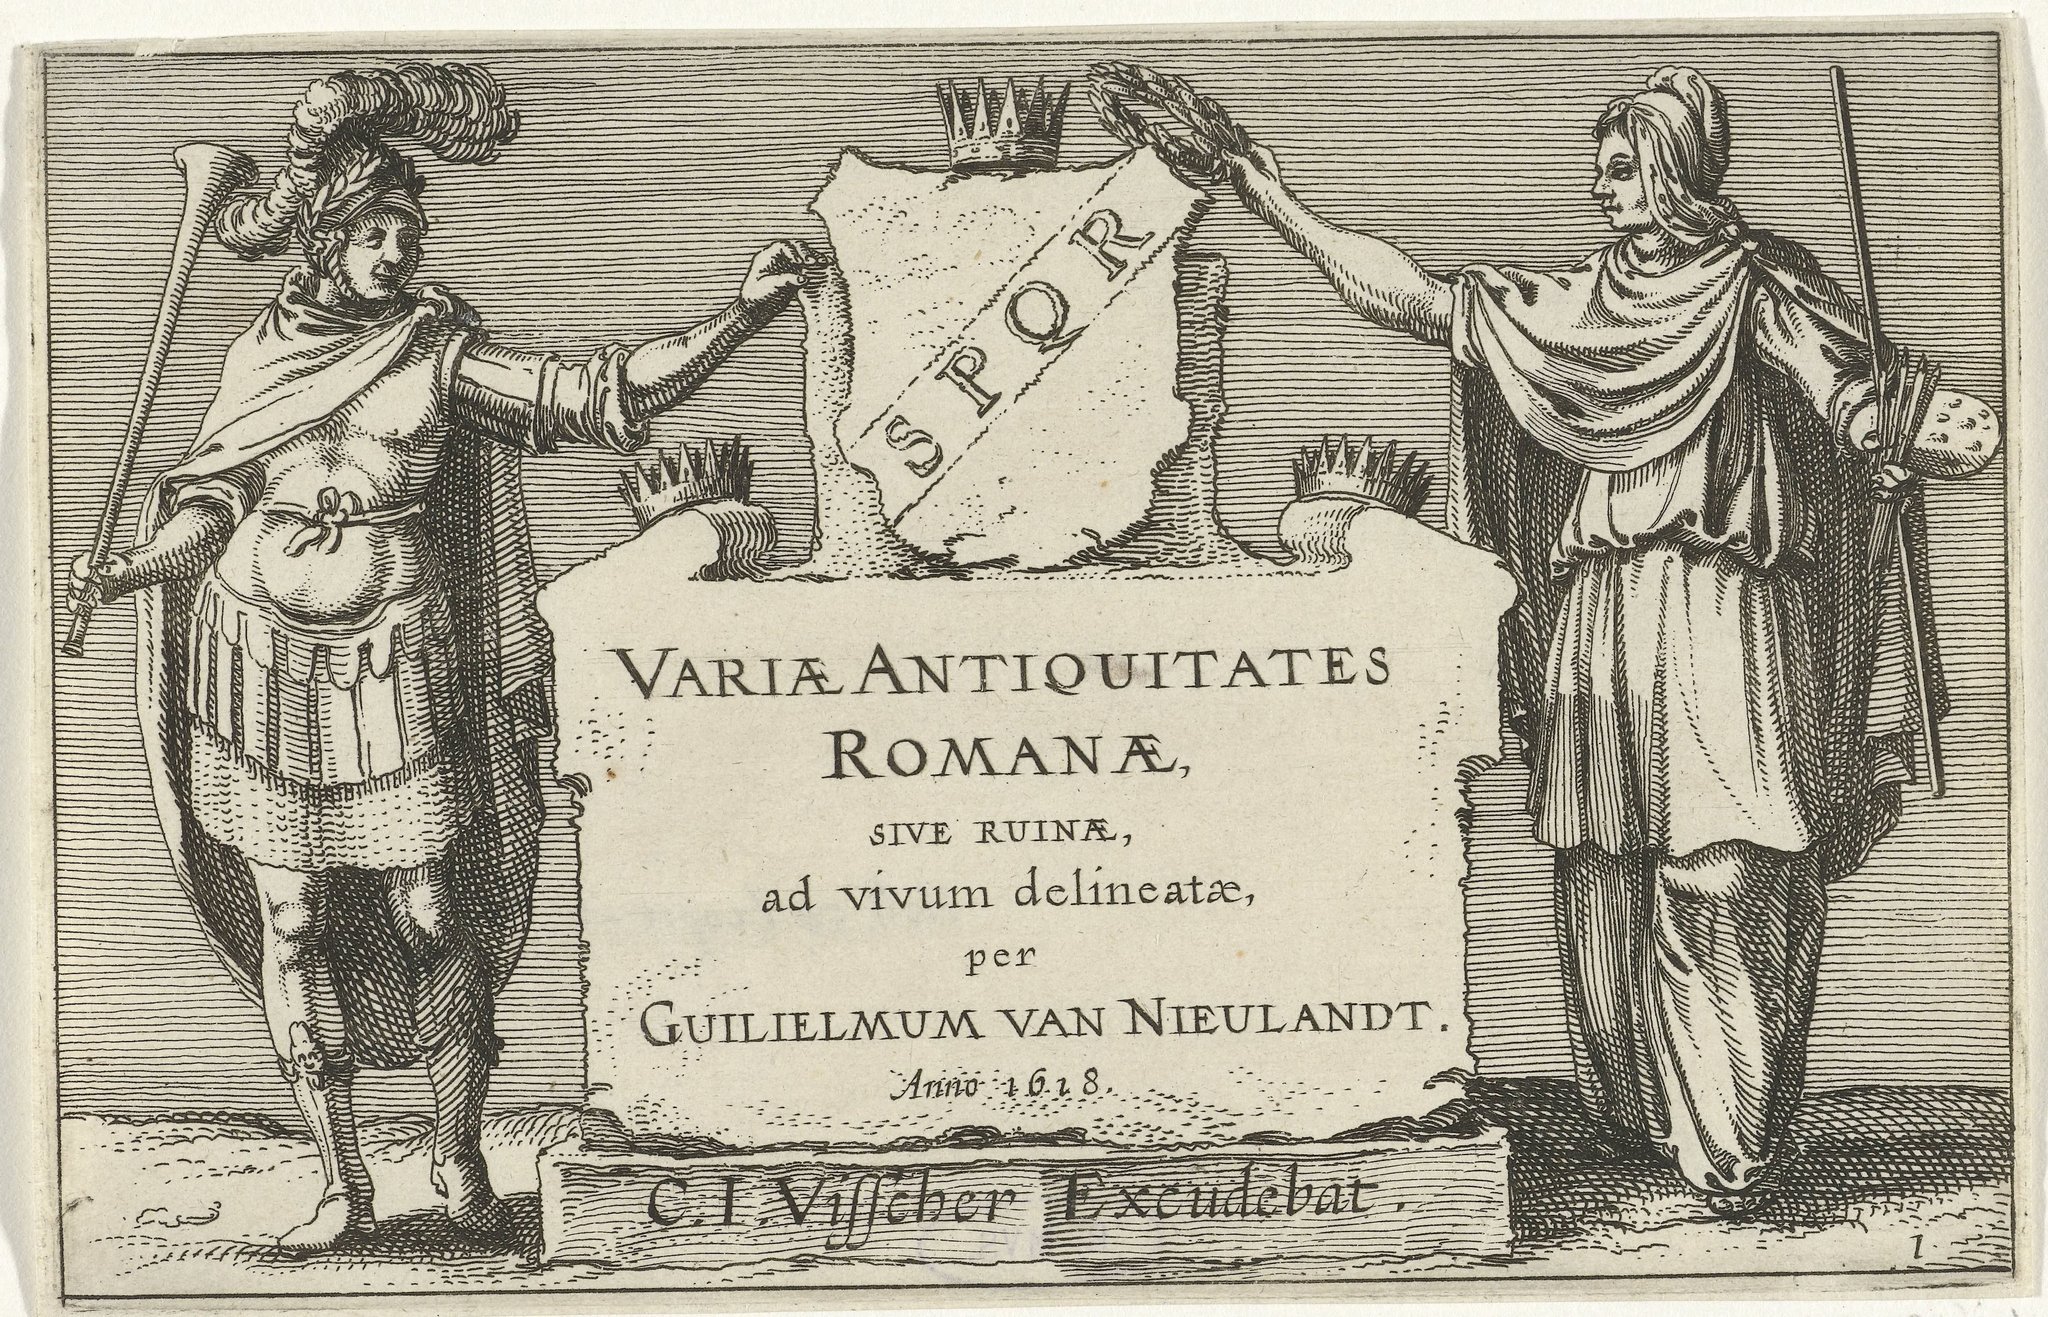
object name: print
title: Romeinse ruïnes en kustlandschappen (serie 1)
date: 1618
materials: paper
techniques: etching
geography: amsterdam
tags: symbolic representations, allegories and emblems ~ art; 'arte' (ripa), fame; 'fama', 'fama buona', 'fama chiara' (ripa), maps of cities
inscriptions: collector's mark: Lugt 2228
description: Een monumentale steen met het Romeinse devies S.P.Q.R. is gekroond met drie kronen. De steen wordt geflankeerd door Faam met een trompet, gekleed als Romeinse soldaat, en door de Schilderkunst, met schildersstok, penselen en palet, die de steen met een lauwerkrans kroont. Titelprent van een serie Romeinse ruïnes en kustlandschappen naar een prentserie van Willem van Nieulandt.